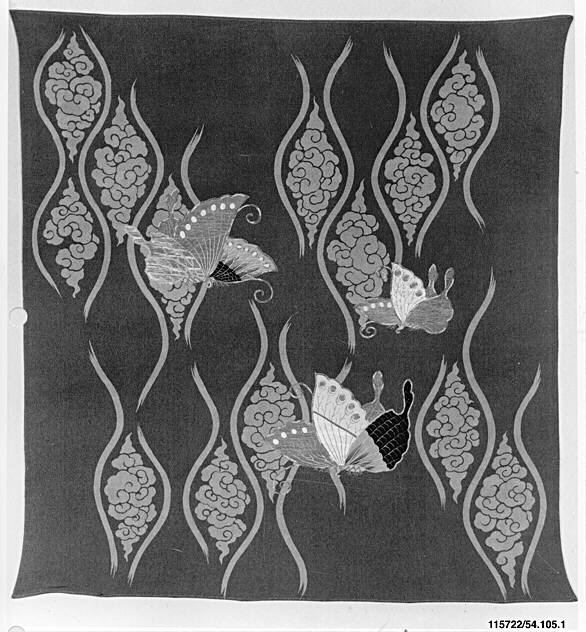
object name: square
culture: japanese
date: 1901-2000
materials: silk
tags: butterflies